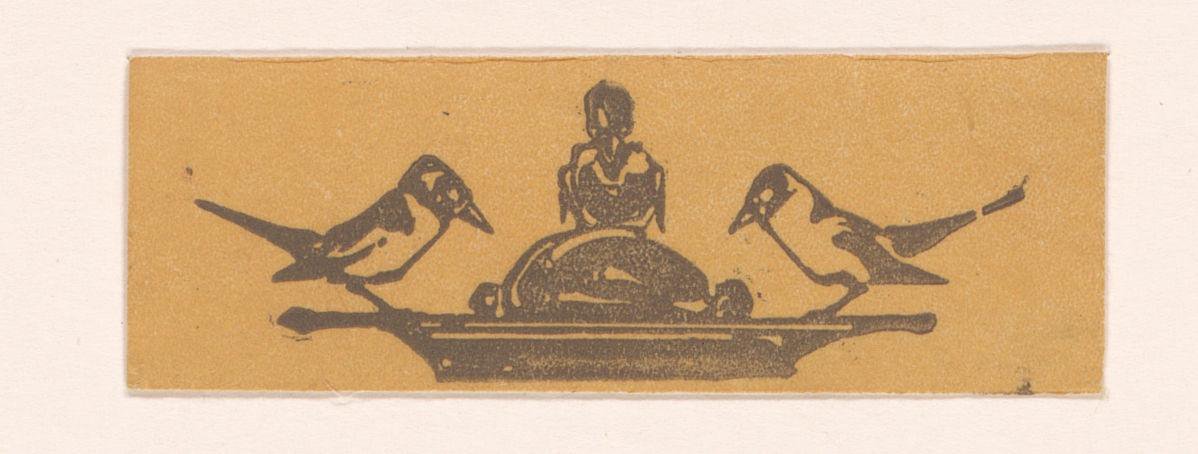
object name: boekillustratie ontwerp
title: Eksters op schaal met kip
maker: bernard willem wierink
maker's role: draughtsman, print maker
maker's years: 1856-1939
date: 1910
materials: paper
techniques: relief print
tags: fable of reynard the fox, song-birds: magpie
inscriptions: collector's mark: Lugt 2228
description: Ontwerp voor: Streuvels, Stijn (Frank Lateur). Reinaert de Vos naar verschillende uitgaven van het middeleeuwsche epos. Amsterdam: L.J. Veen, 1910. Deze prent is vermoedelijk een plaatsnede, ook al wordt in de literatuur veelal gesproken over een houtsnede. Voor zover Wierink zijn prenten in hoogdruk zelf nader heeft omschreven, heeft hij altijd de term 'plaatsnede' gebruikt.